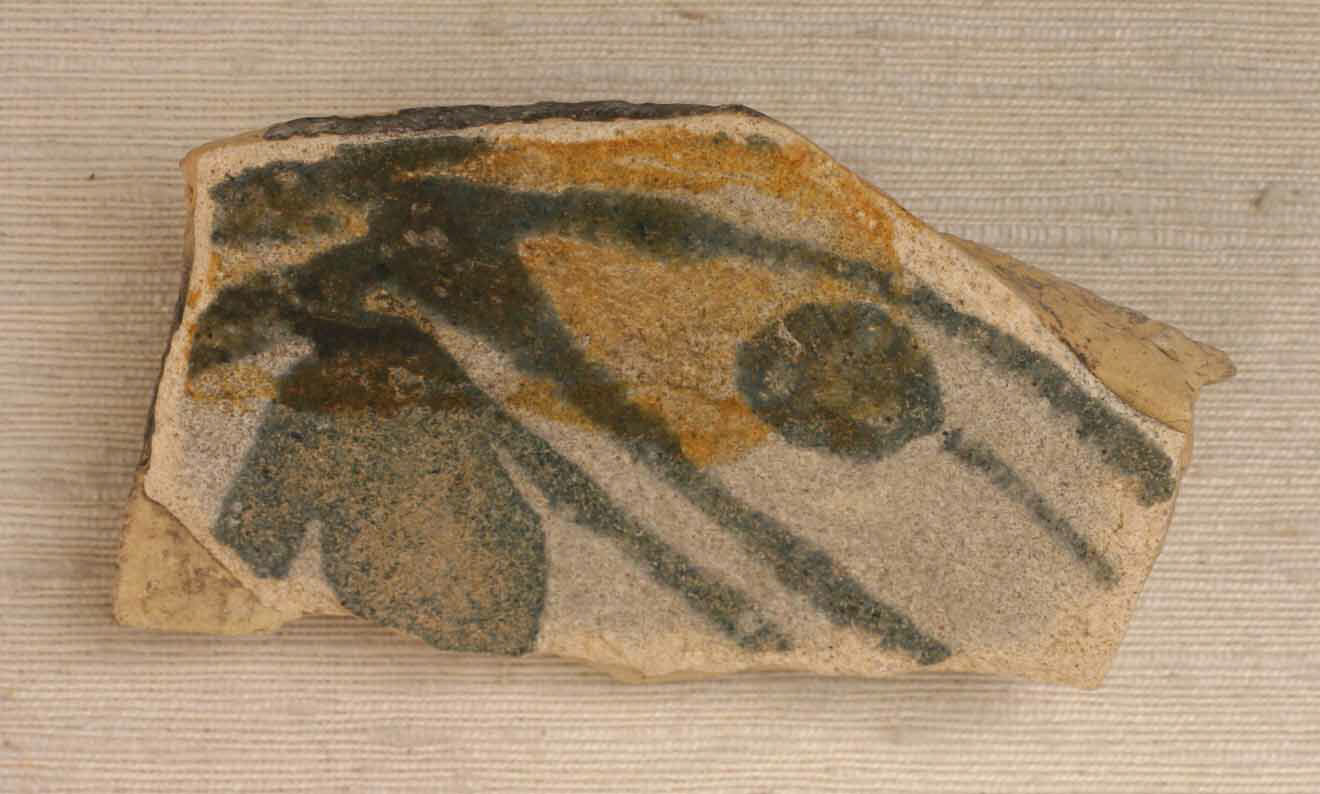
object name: fragment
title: Ceramic Fragment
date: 801-1000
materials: earthenware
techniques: glazing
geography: saudi arabia